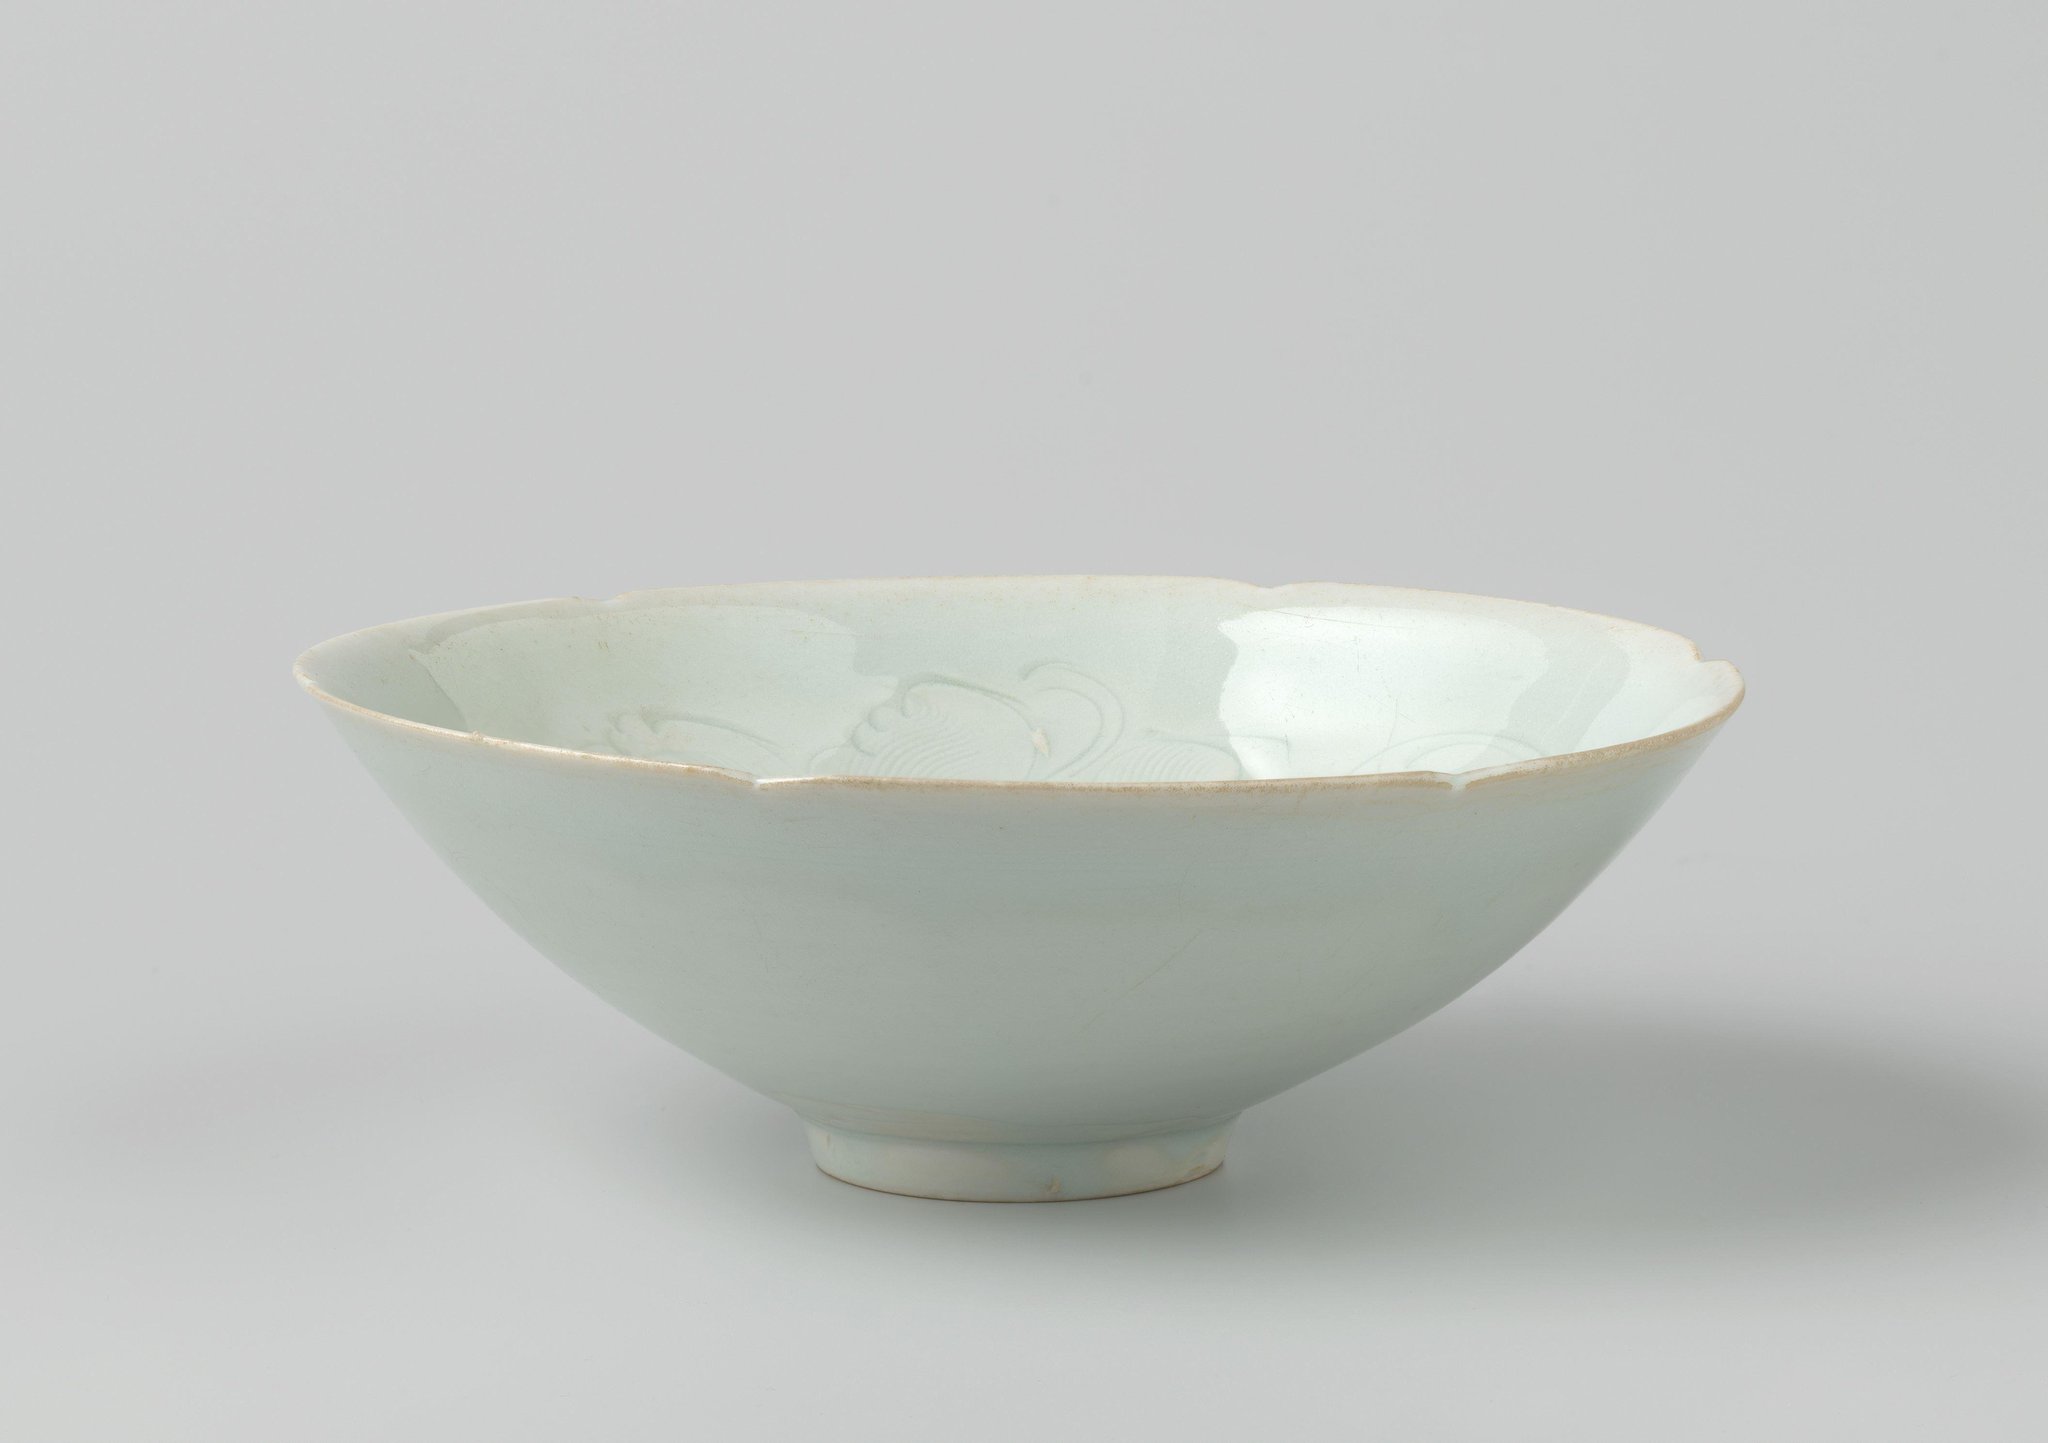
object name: bowl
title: Kom met ingesneden pioenrozen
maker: Anonymous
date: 1000-1199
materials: ceramic, earthenware, stoneware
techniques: vitrification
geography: china